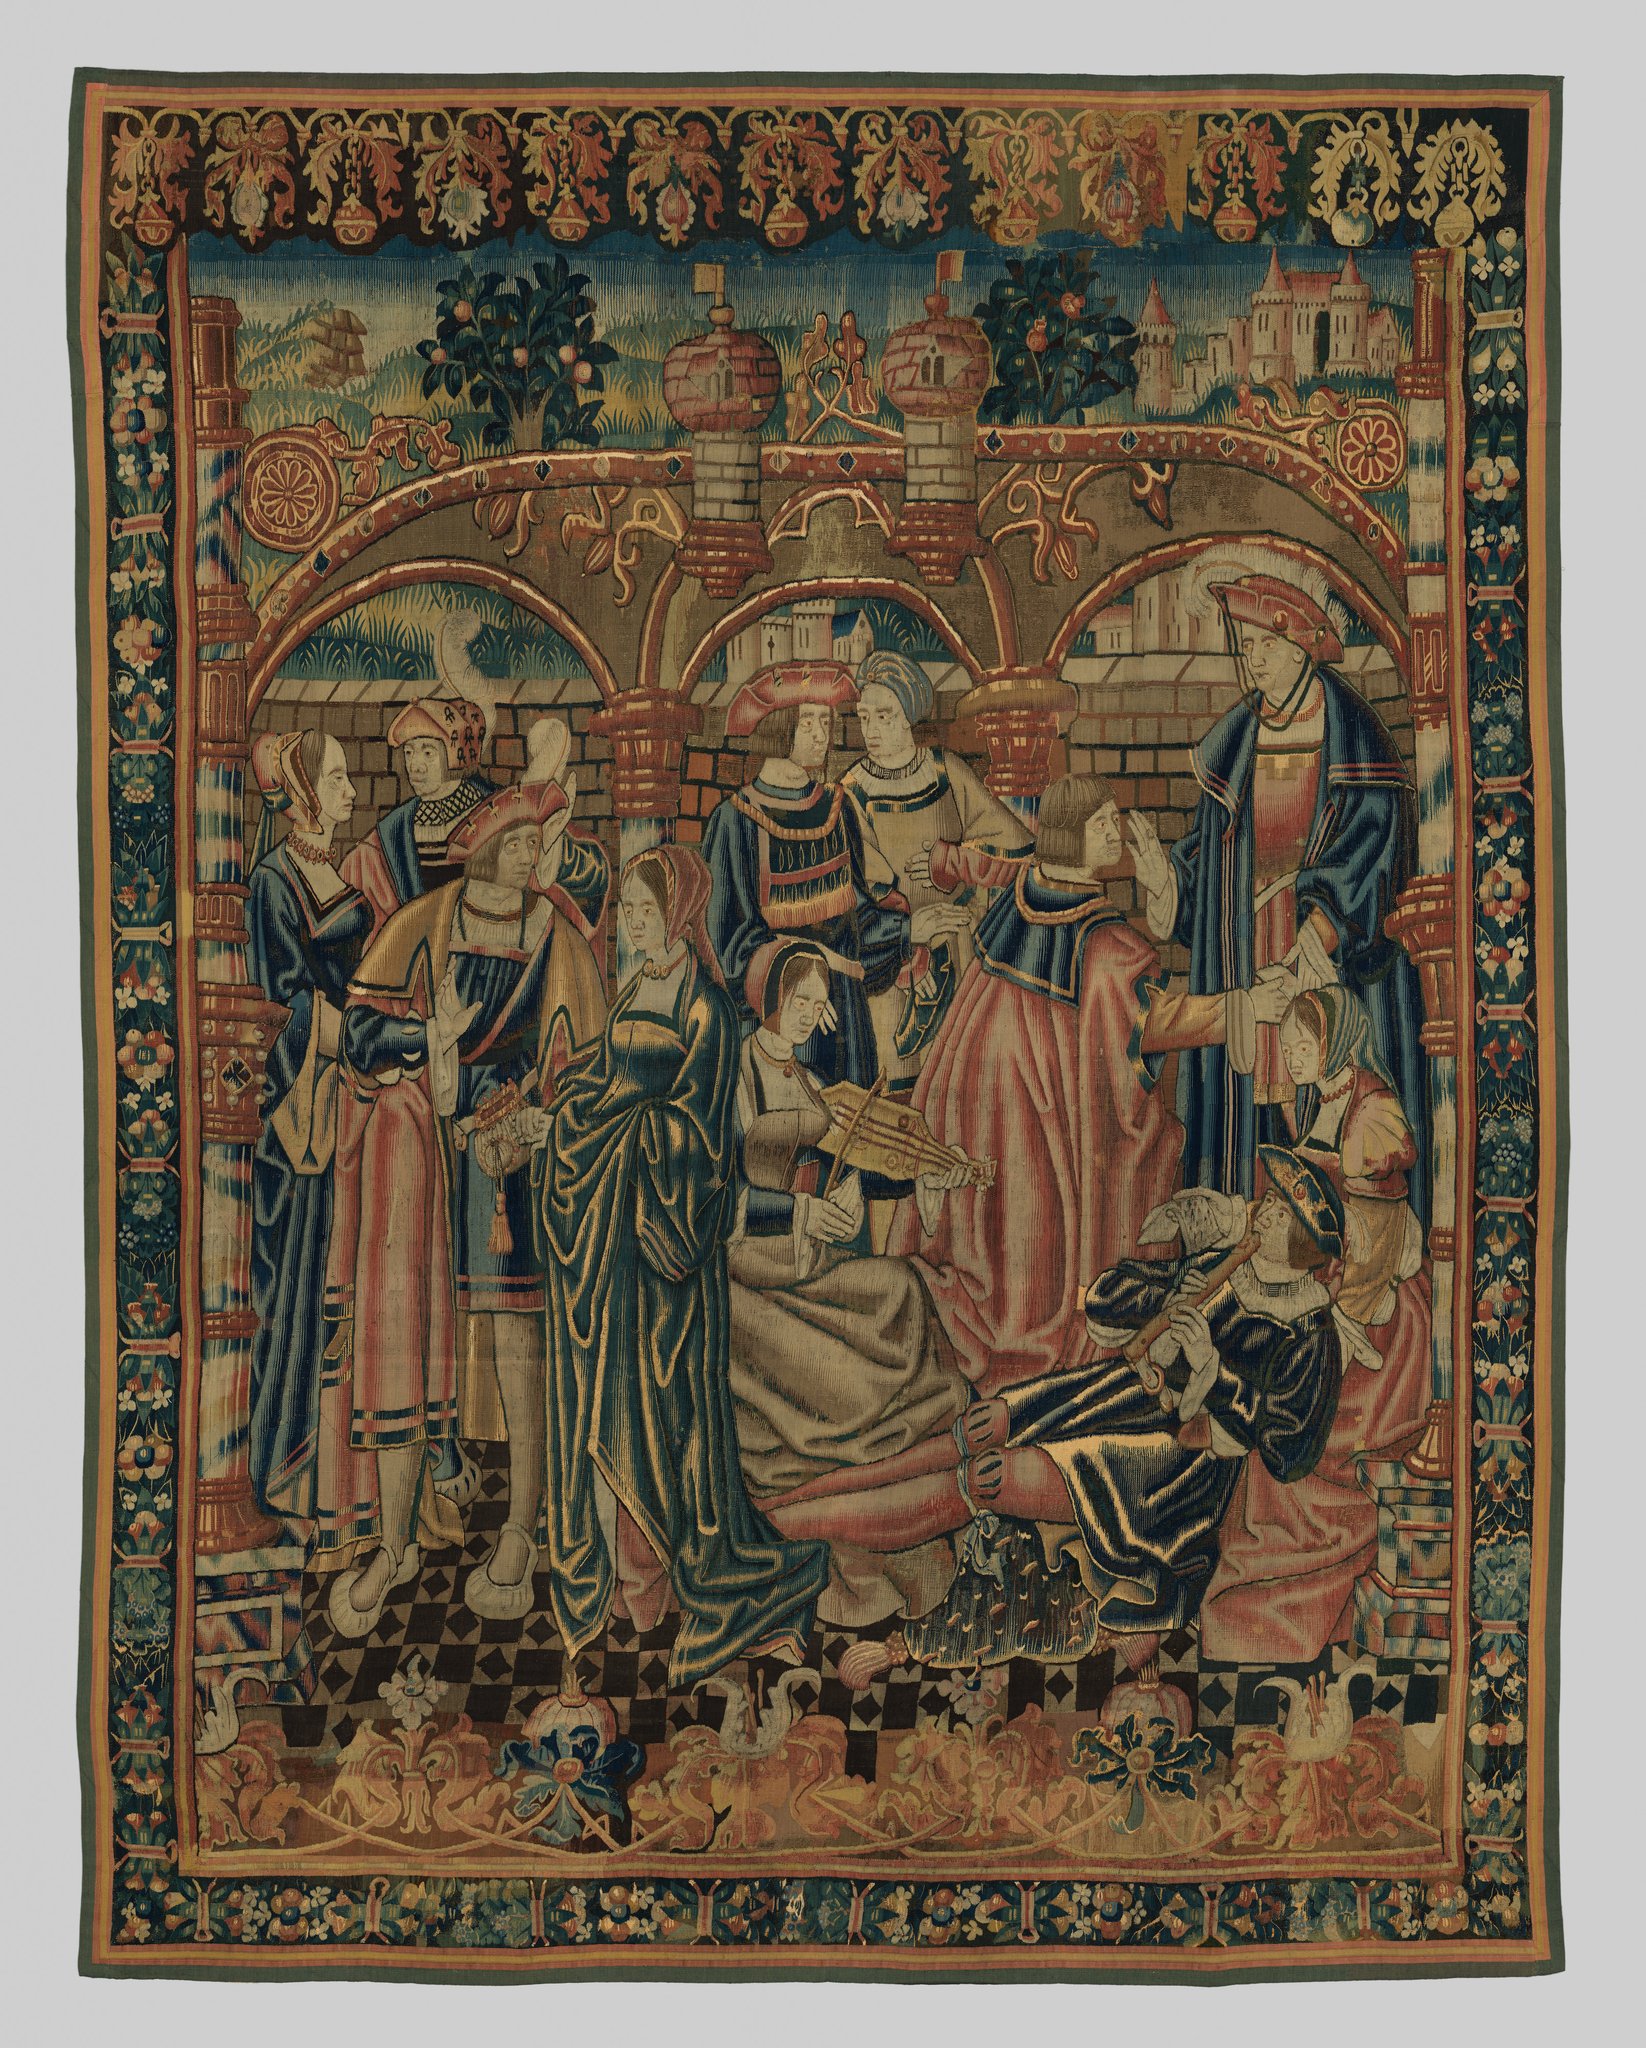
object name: tapestry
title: Four Episodes in the Story of Hercules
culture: south netherlandish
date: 1515-1535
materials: silk, wool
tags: women